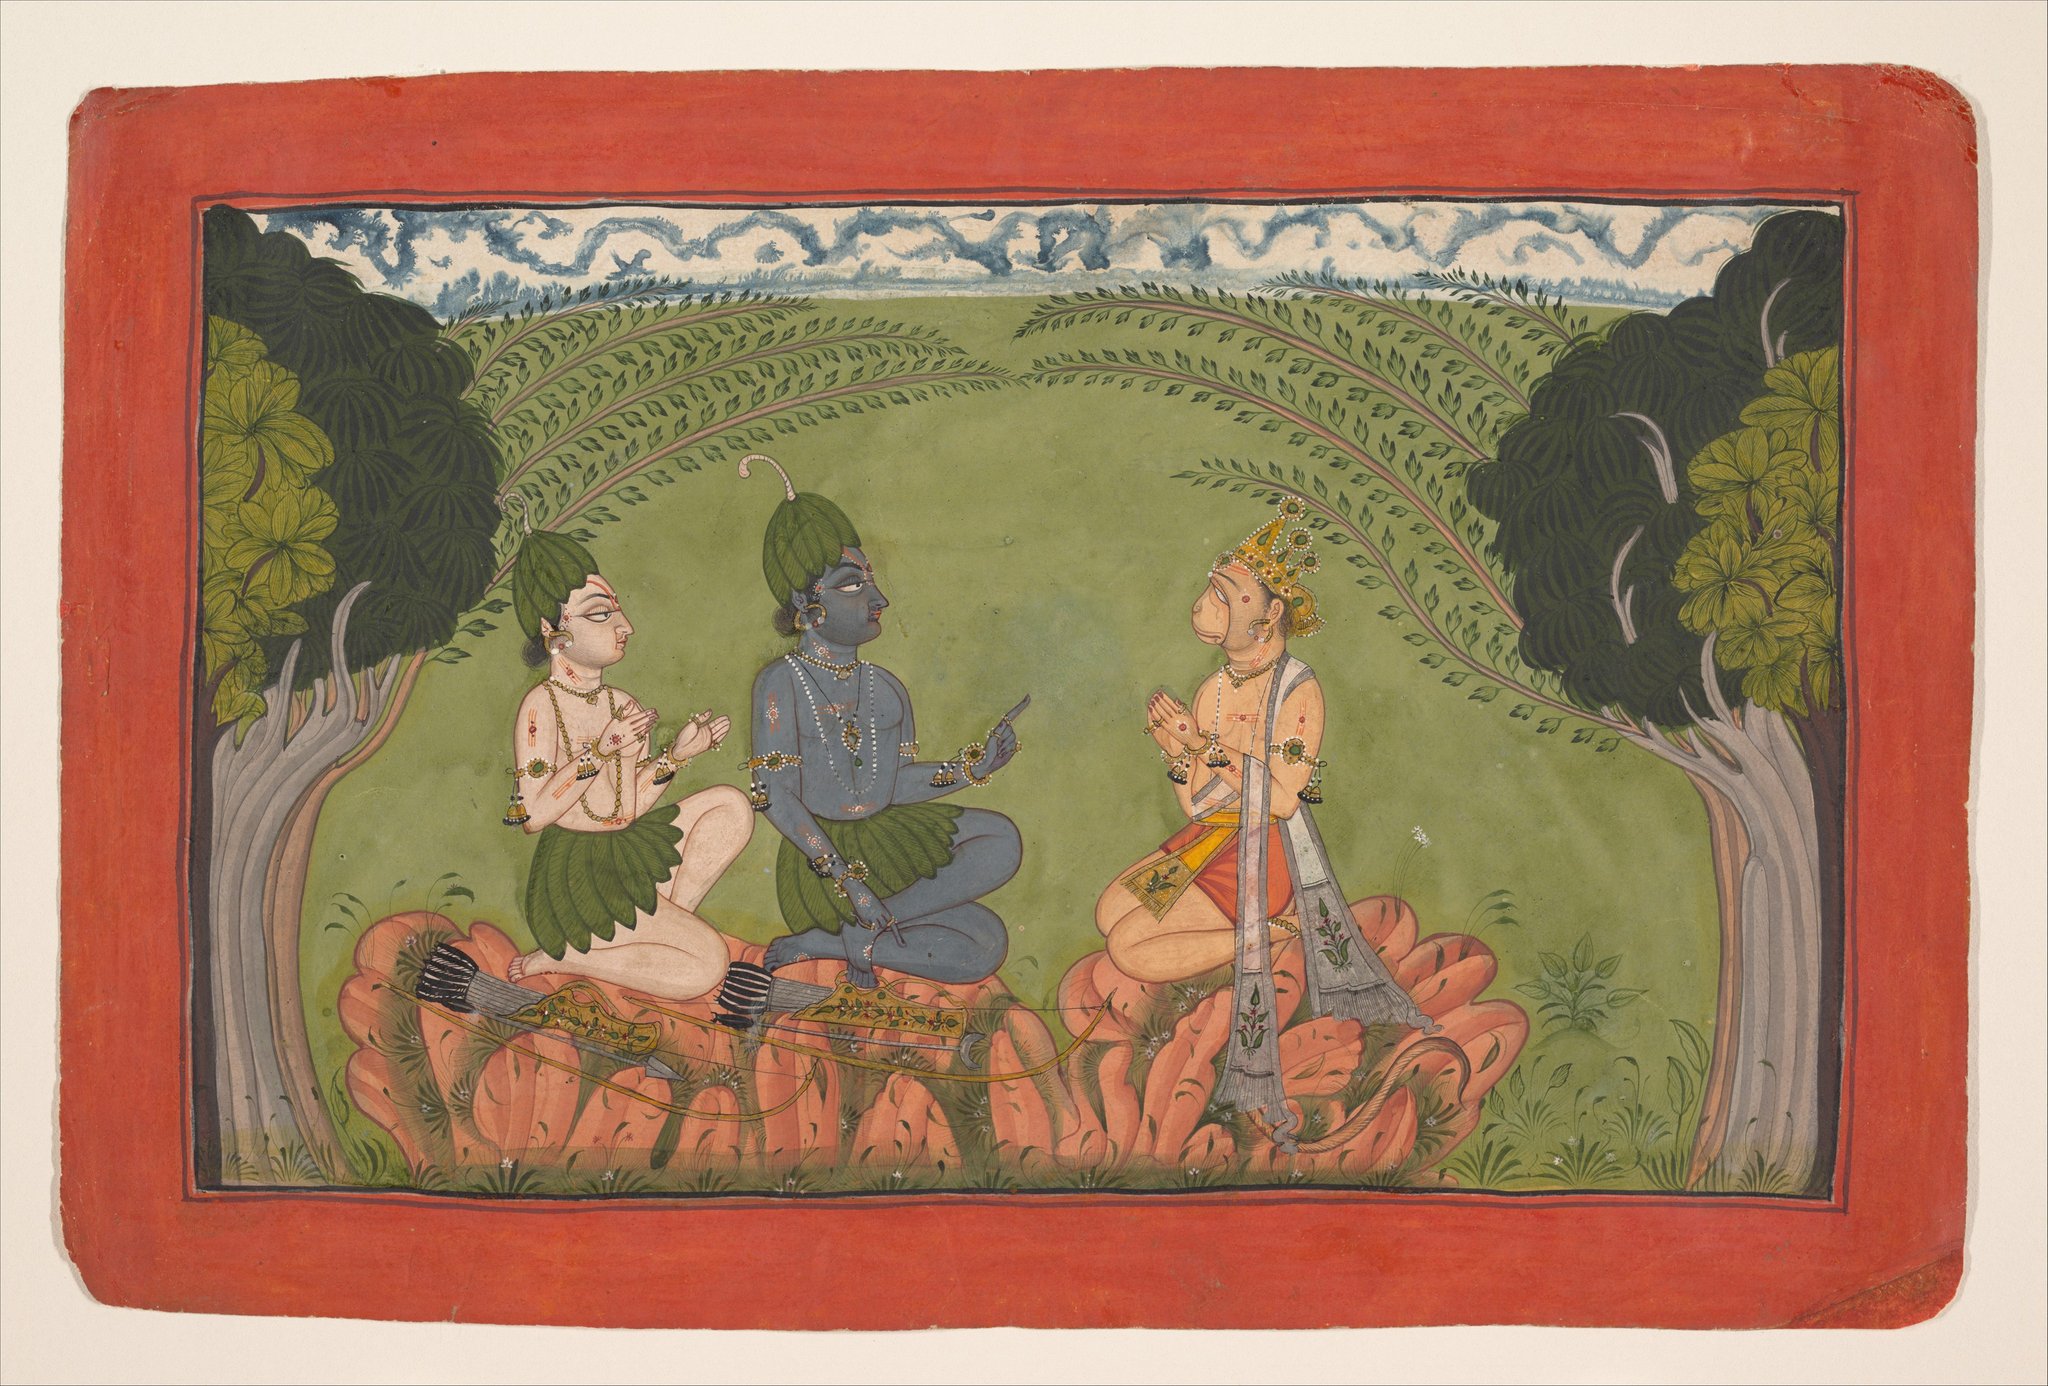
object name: folio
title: Hanuman before Rama and Lakshmana: Folio from the dispersed “Mankot" Ramayana series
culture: indian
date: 1710-1725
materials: ink, paper, watercolor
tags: men,monkeys